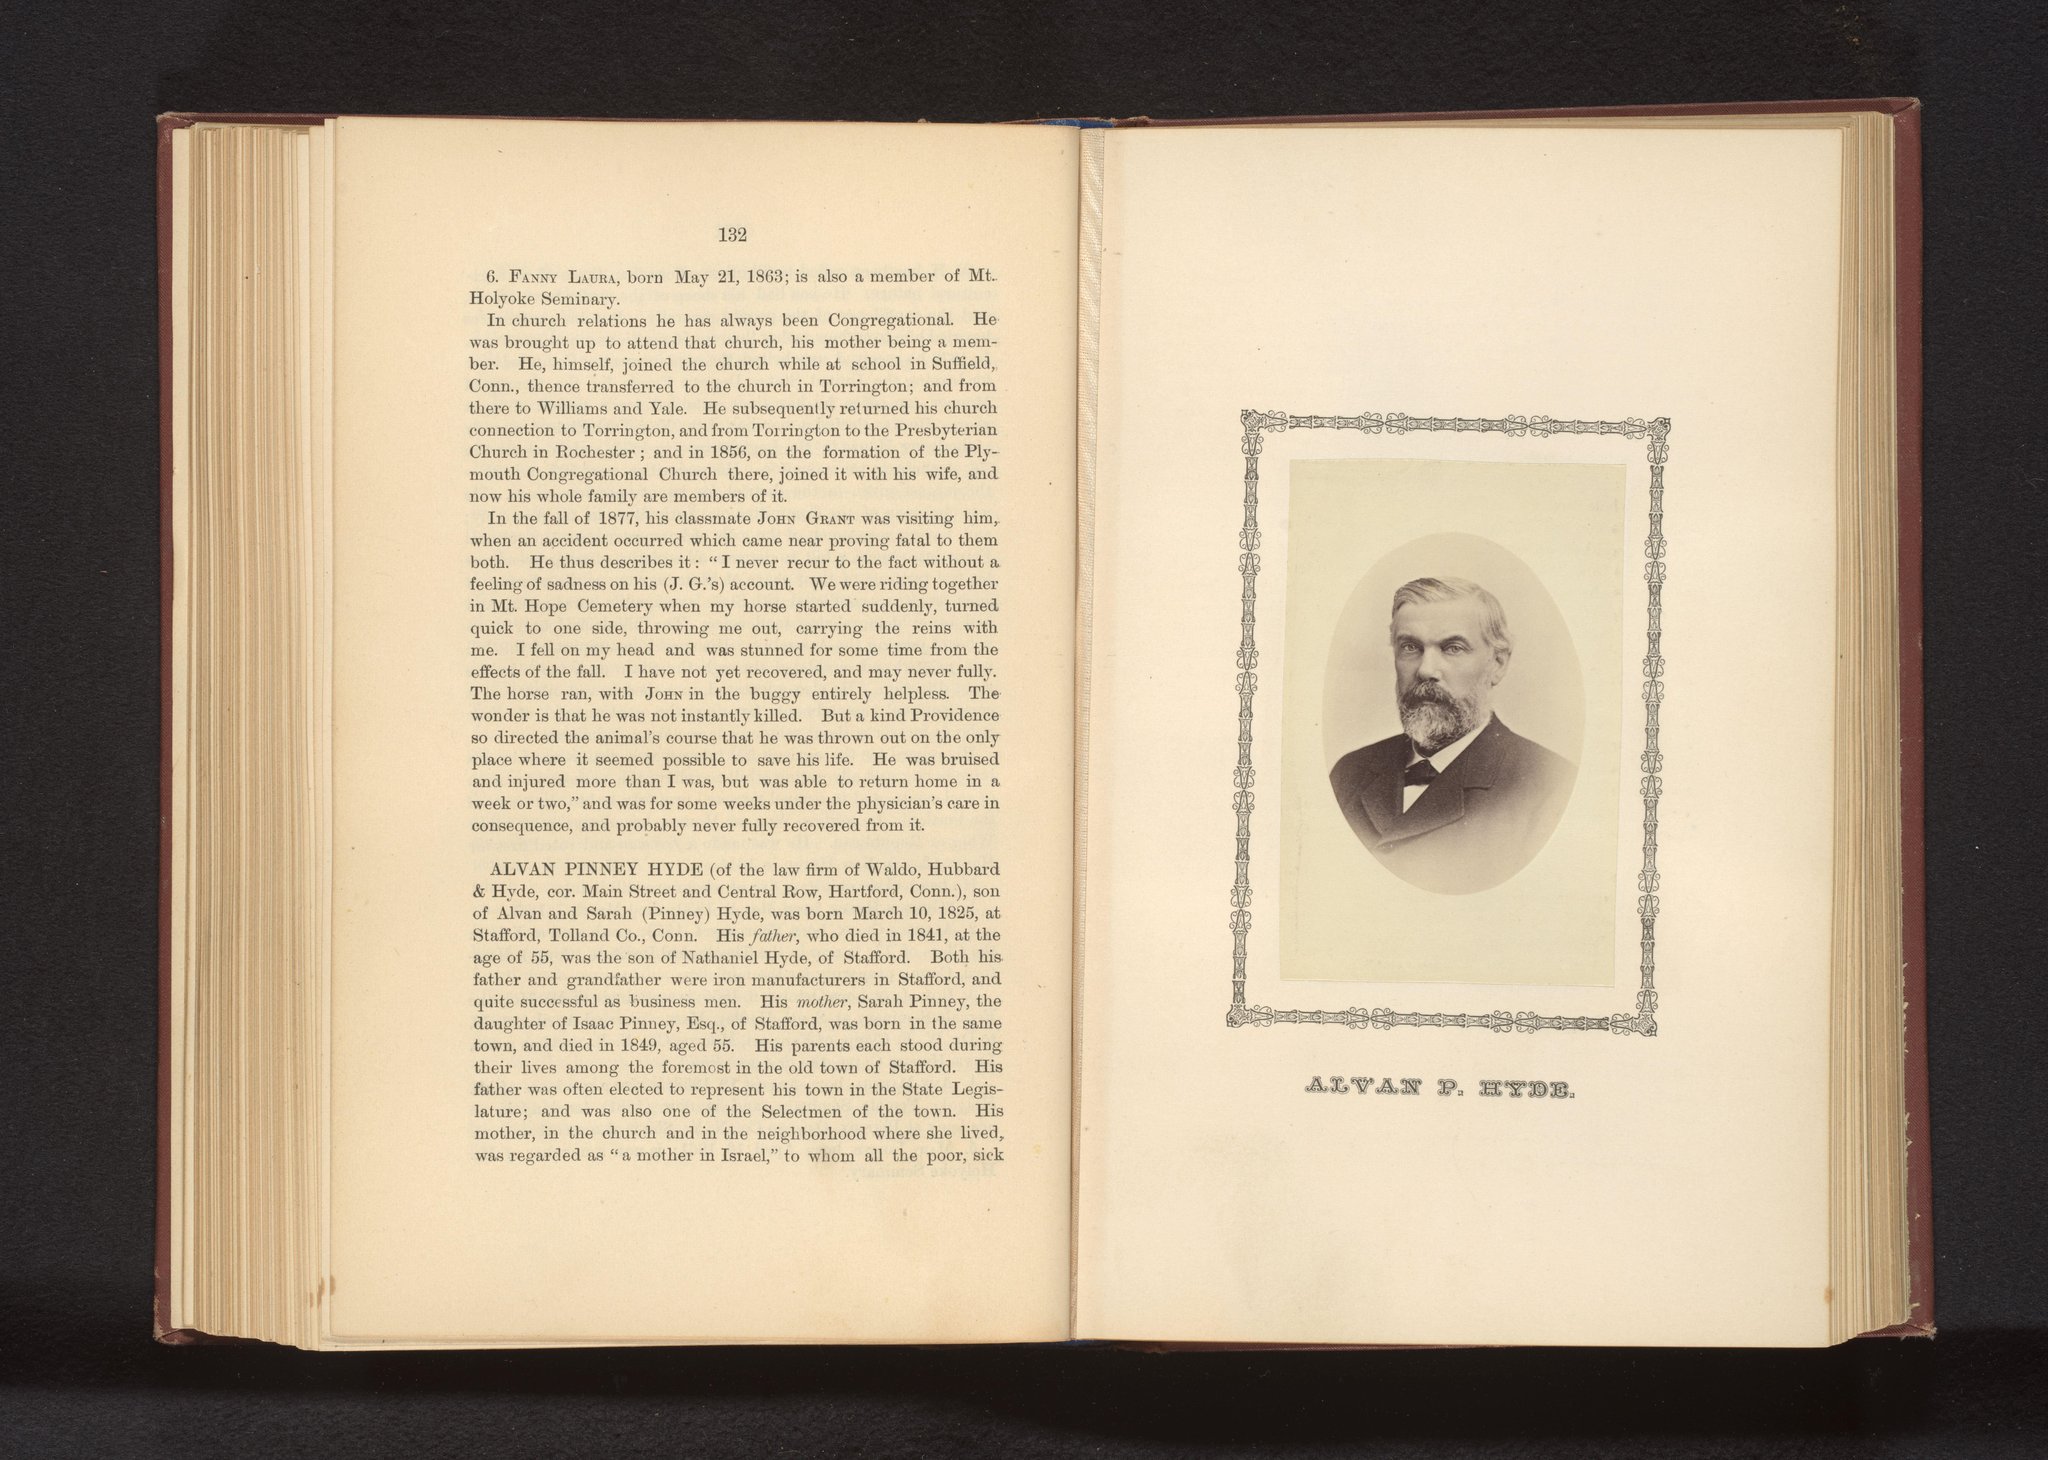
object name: page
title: Alvan P. Hyde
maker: Anonymous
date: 1876-1881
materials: photographic support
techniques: albumen print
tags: adult man